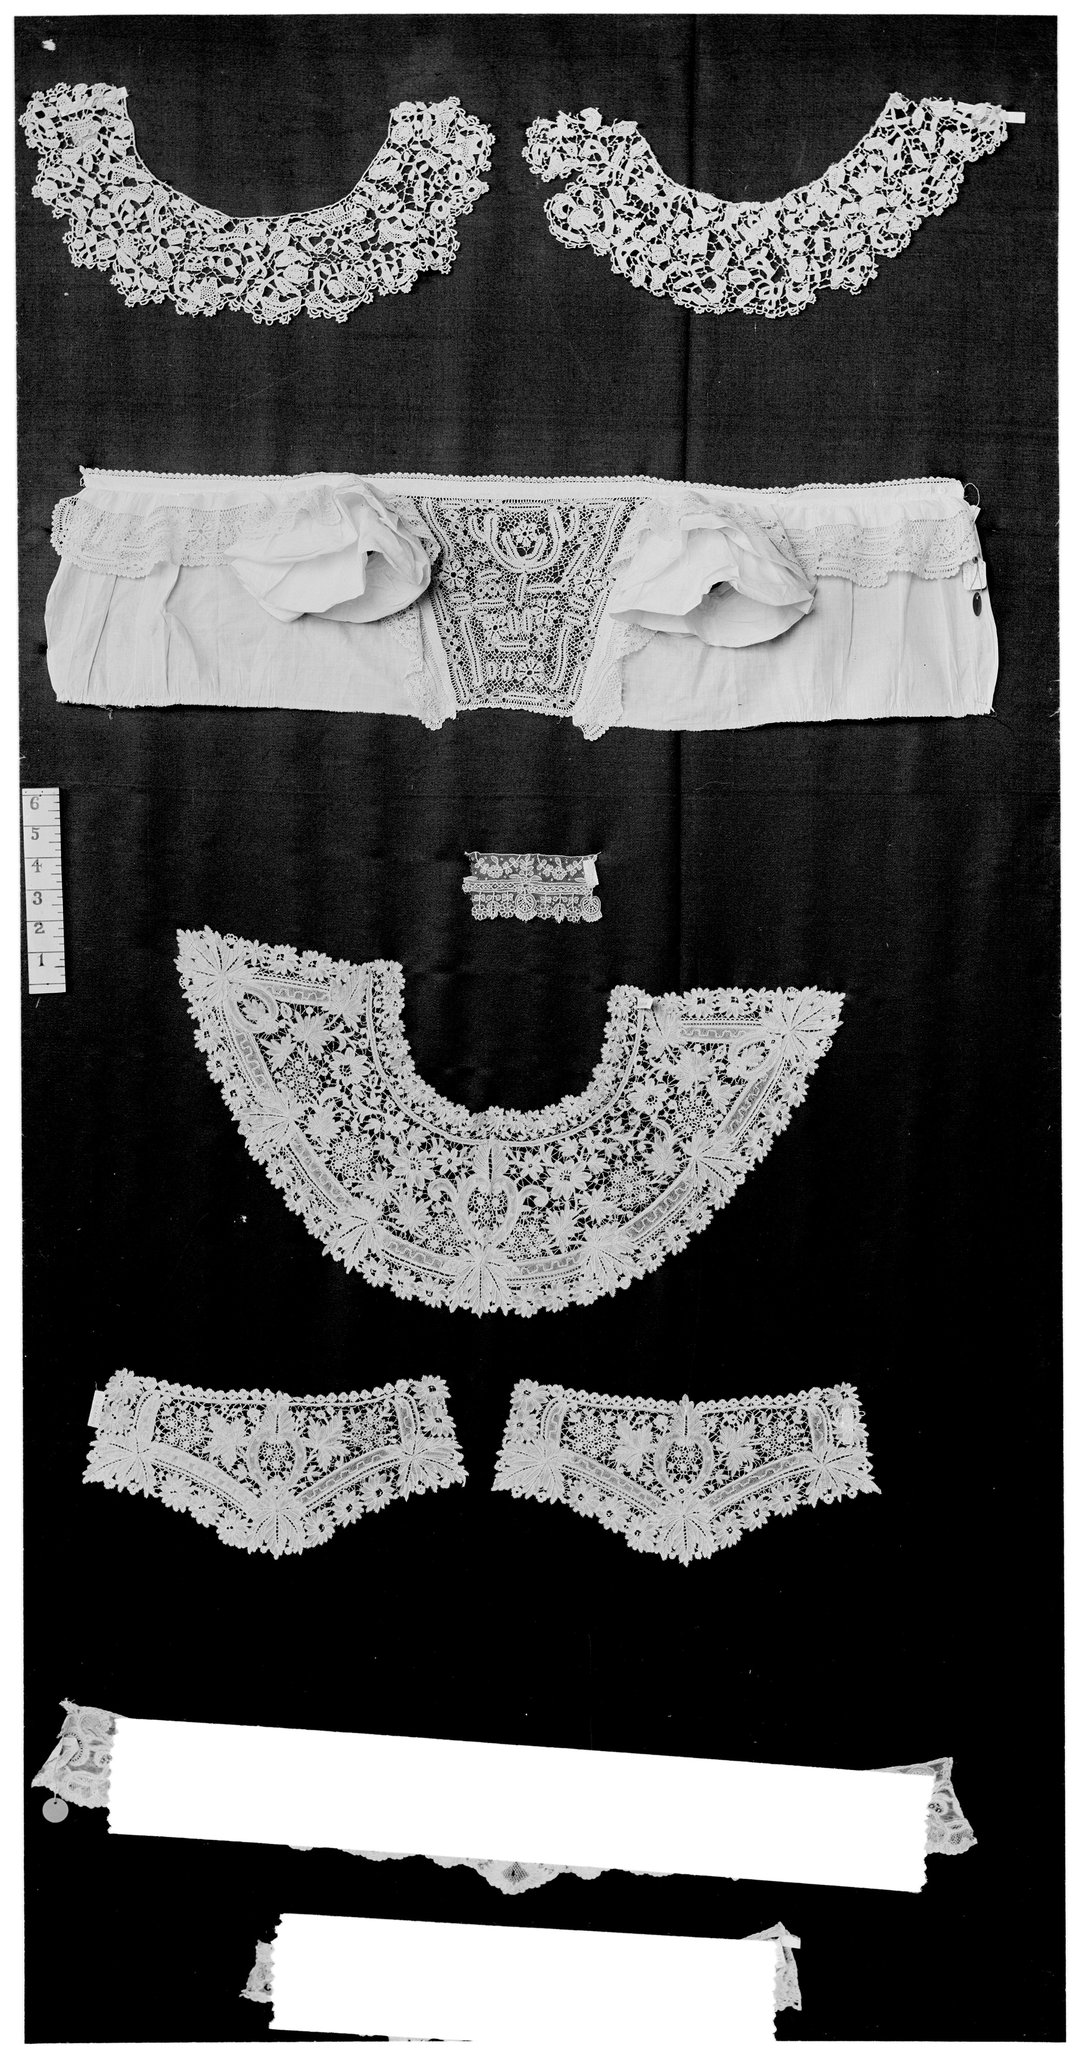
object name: collar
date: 1867-1900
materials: lace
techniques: lace